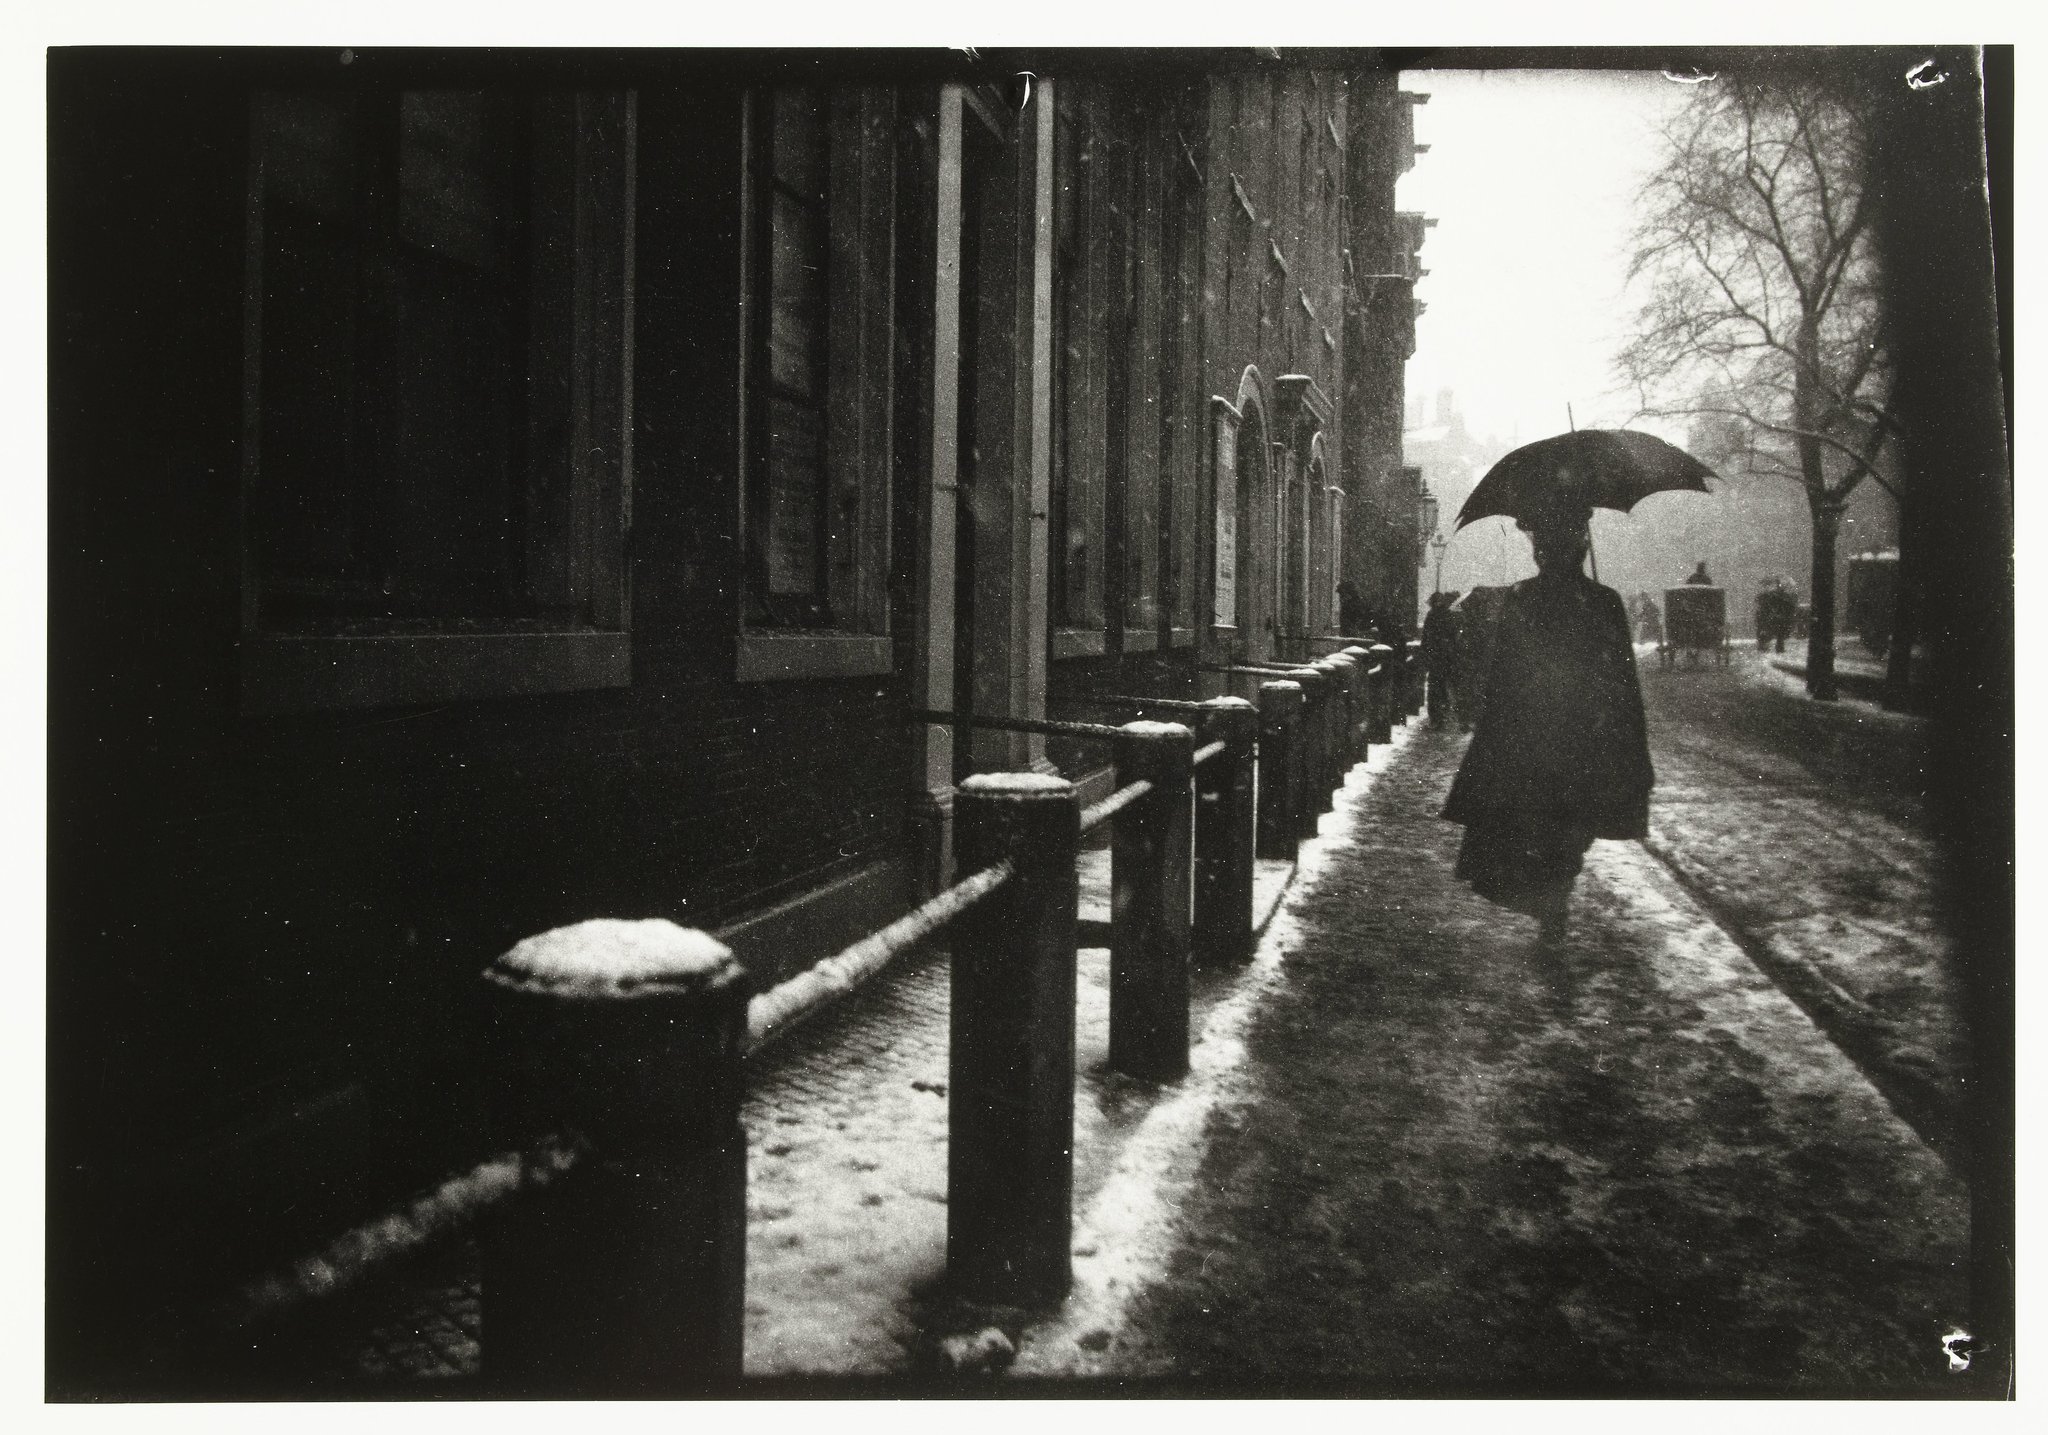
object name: photograph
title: Gezicht op de Singel in Amsterdam op een regenachtige dag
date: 1890-1910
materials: paper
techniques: gelatin silver print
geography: amsterdam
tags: singel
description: Moderne afdruk van negatief BR 893 (collectie RKD).